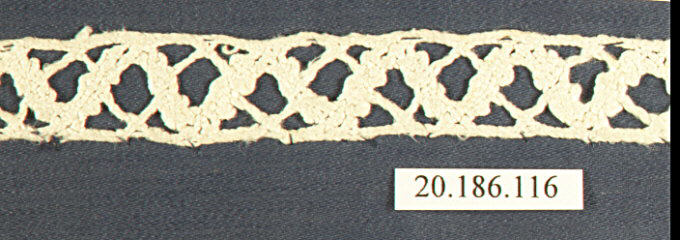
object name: insertion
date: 1501-1700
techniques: lace